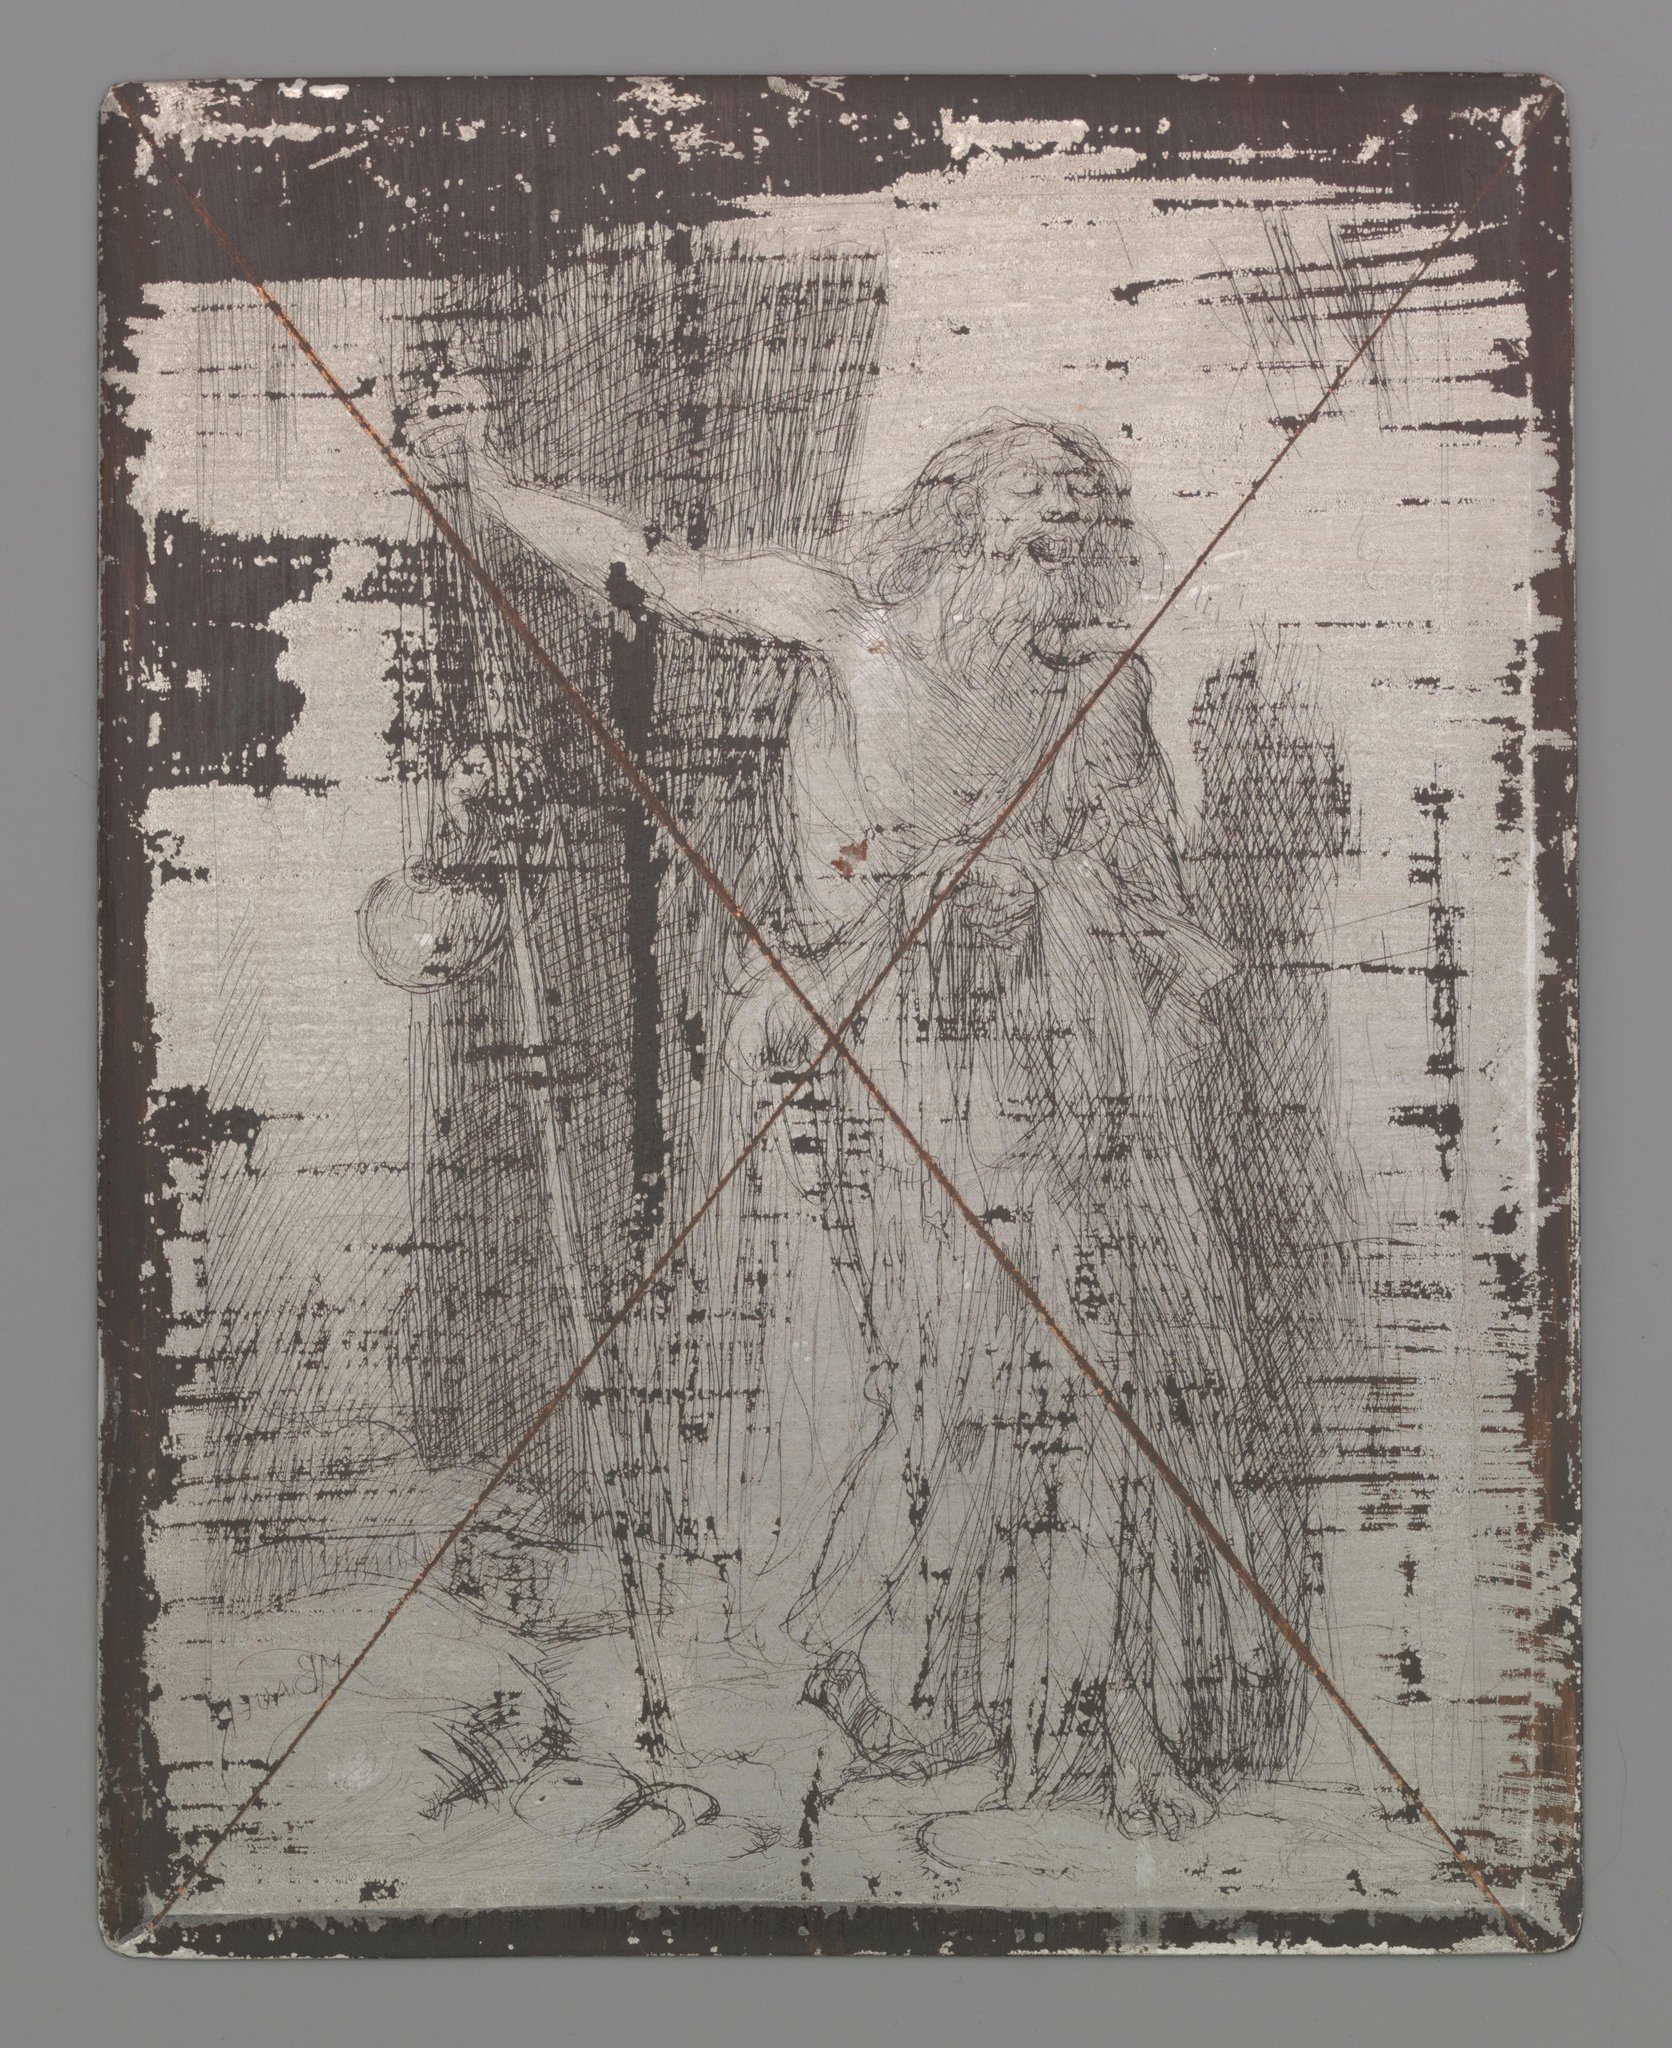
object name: copper plate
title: Blinde bedelaar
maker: marius bauer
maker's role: draughtsman, print maker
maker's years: 1867-1932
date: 1924-1932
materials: copper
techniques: etching